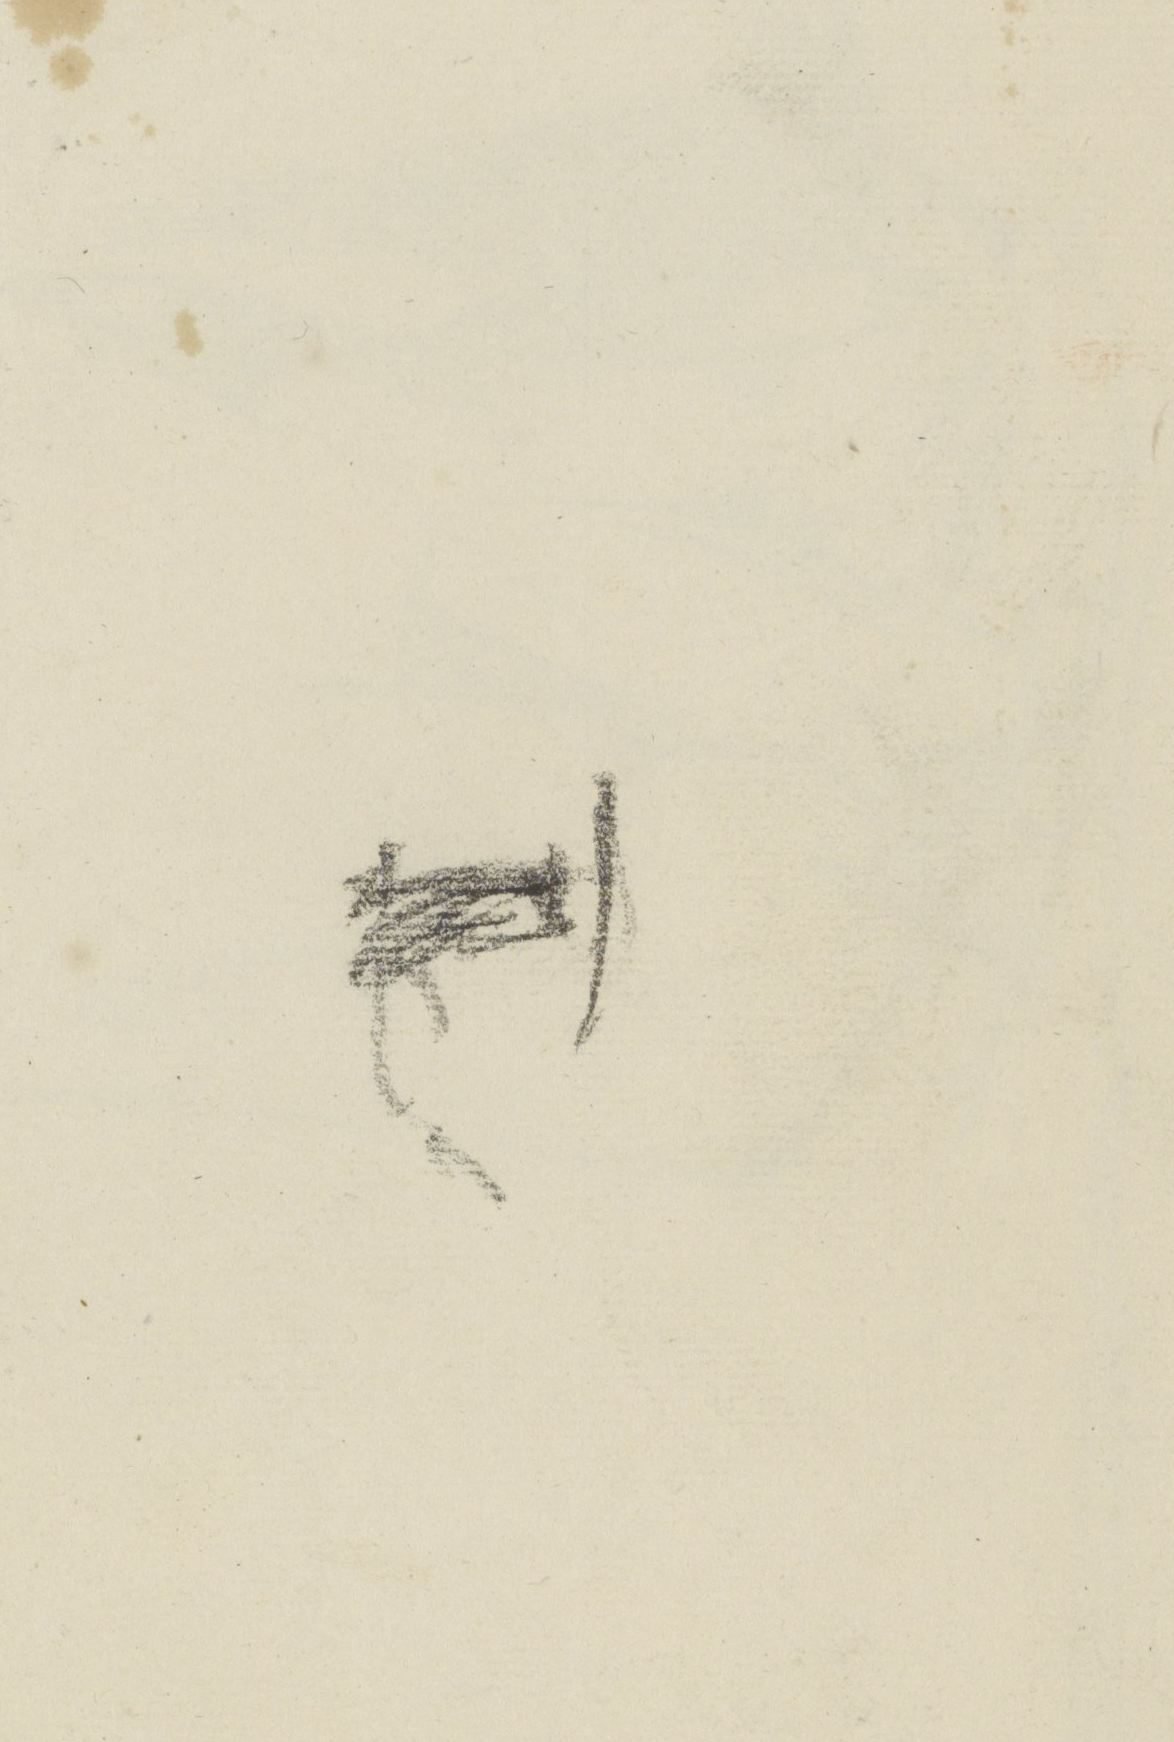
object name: sketchbook leaf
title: Studie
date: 1904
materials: chalk, paper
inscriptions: workshop stamp: Lugt 291d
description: Pagina 22 uit een schetsboek met 14 bladen.